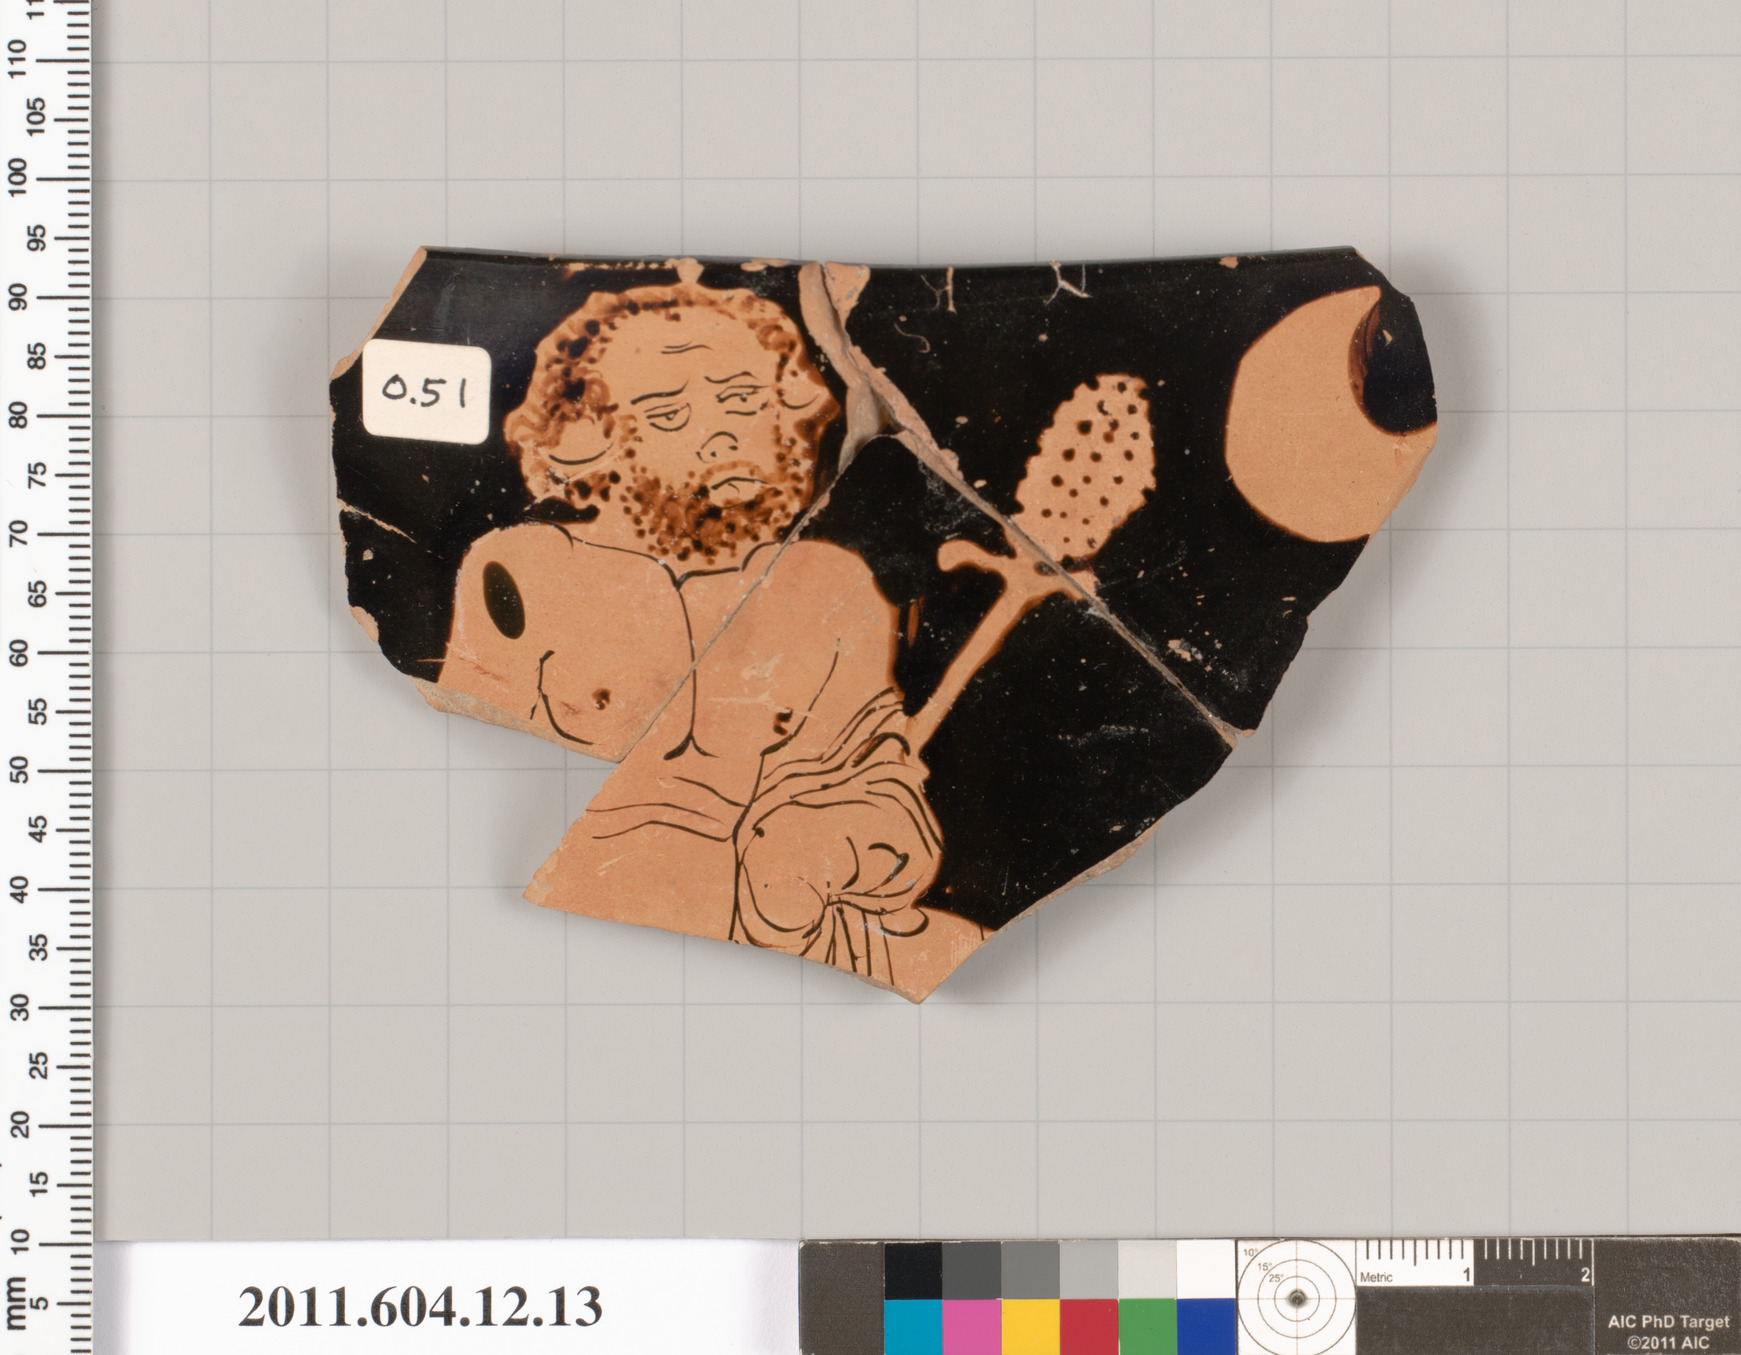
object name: skyphos fragment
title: Terracotta rim fragment of a skyphos (deep drinking cup)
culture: greek, south italian, apulian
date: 350-326 BCE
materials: terracotta